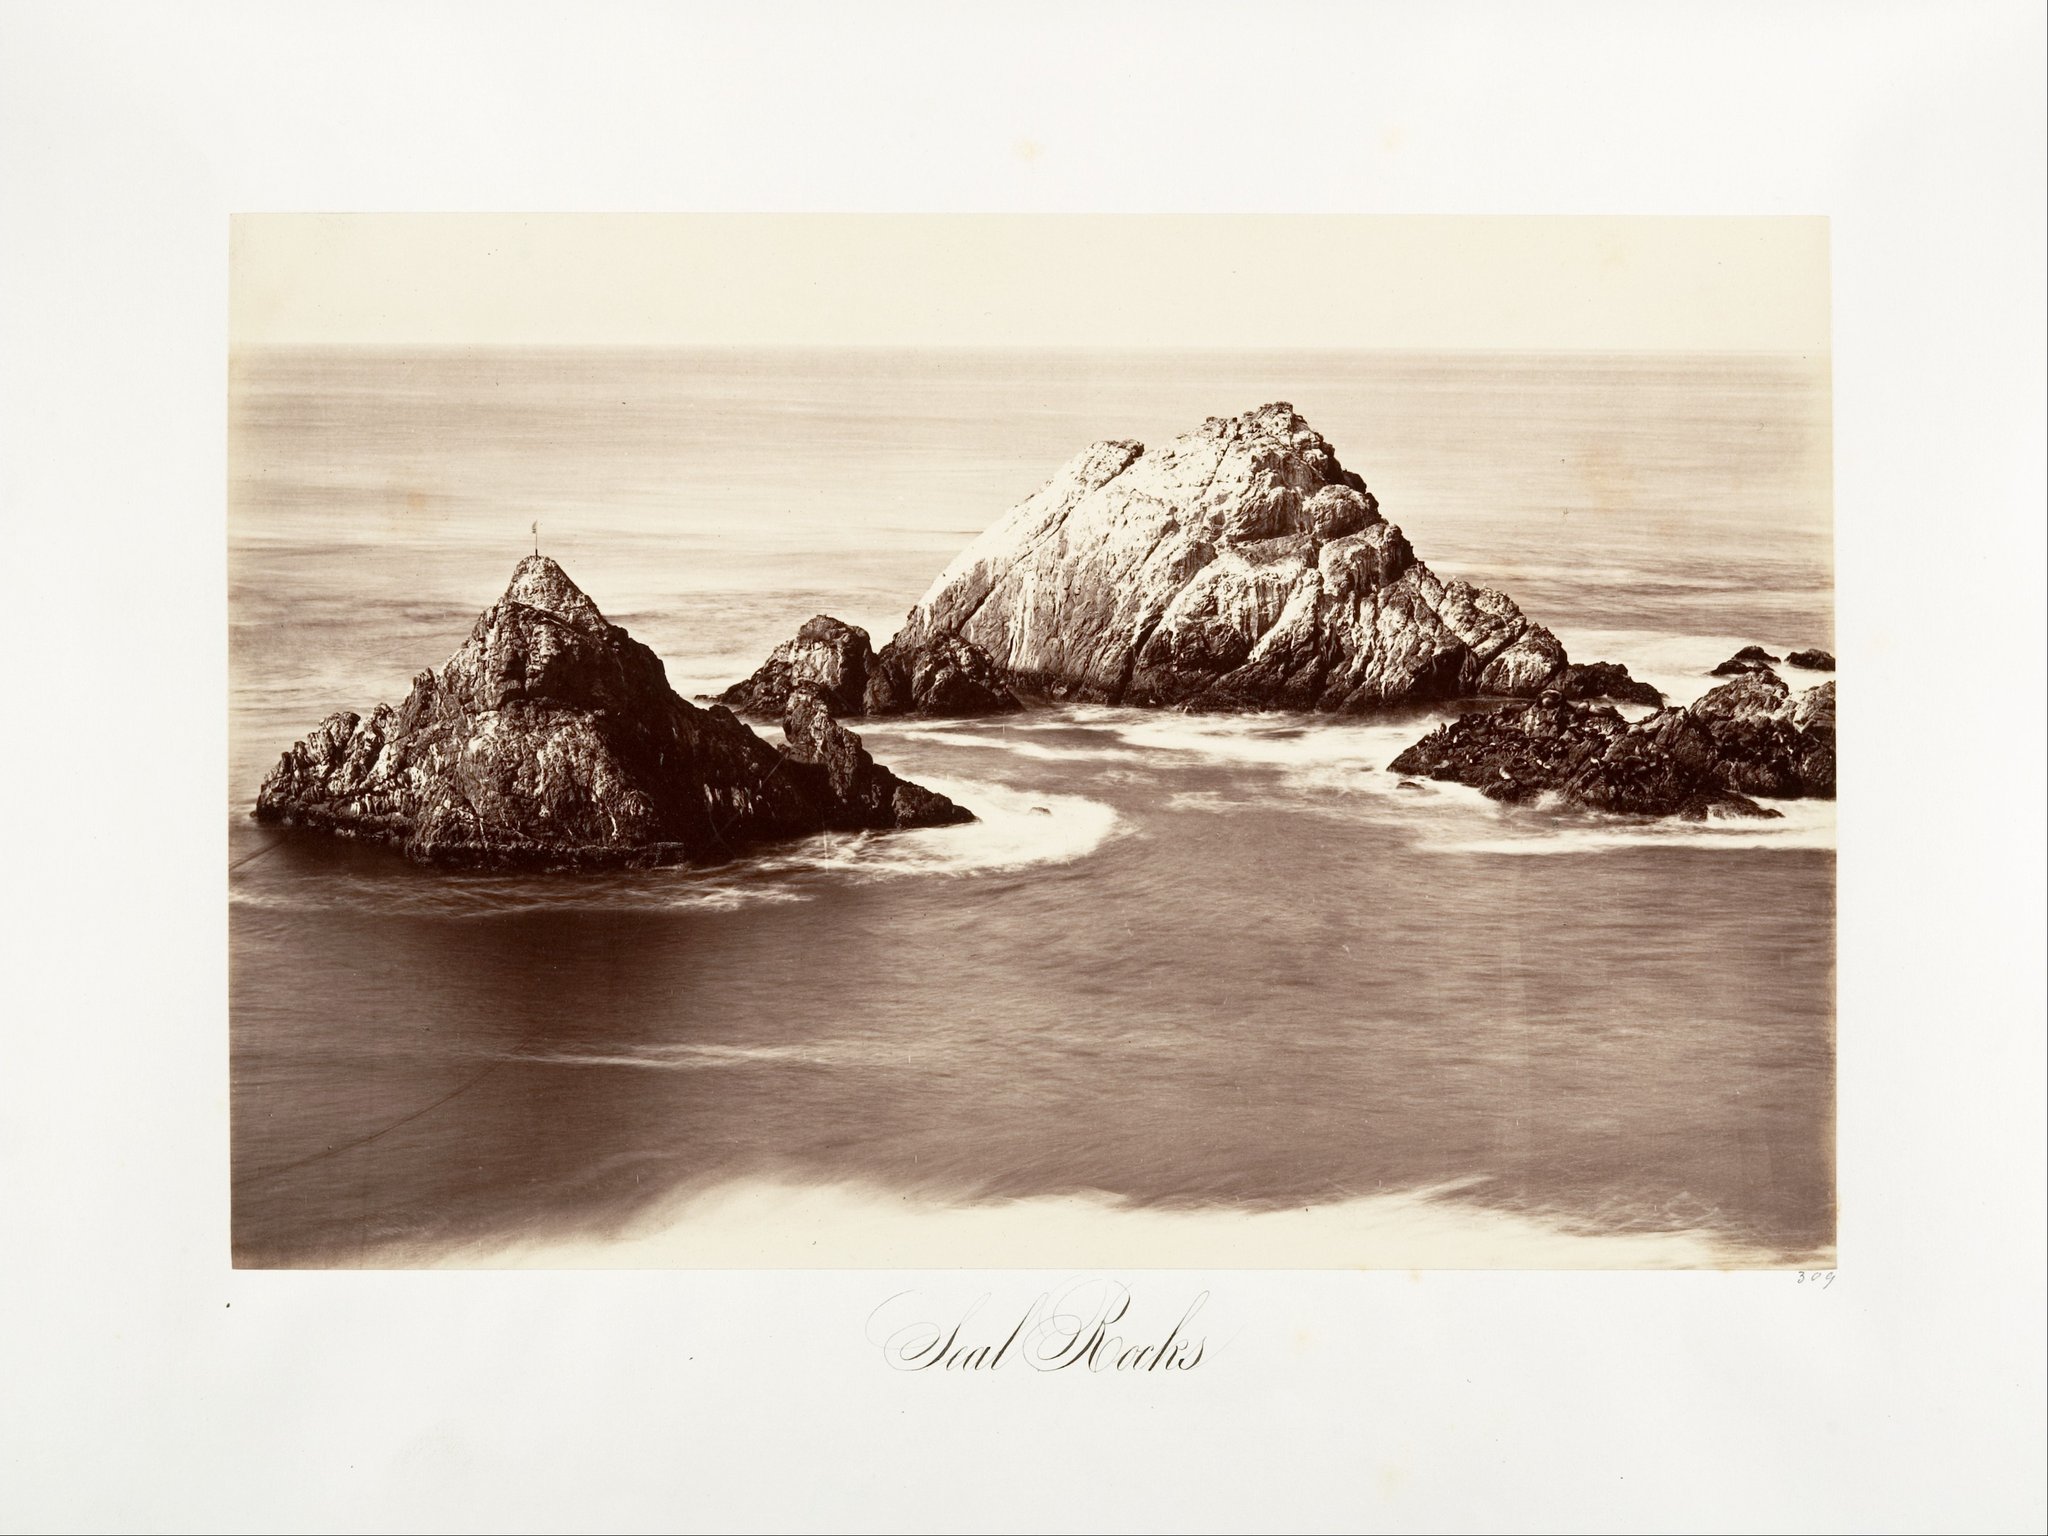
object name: photograph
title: Seal Rocks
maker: carleton e. watkins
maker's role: artist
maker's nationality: american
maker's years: 1829-1916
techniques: albumen silver print, glass negative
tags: seascapes